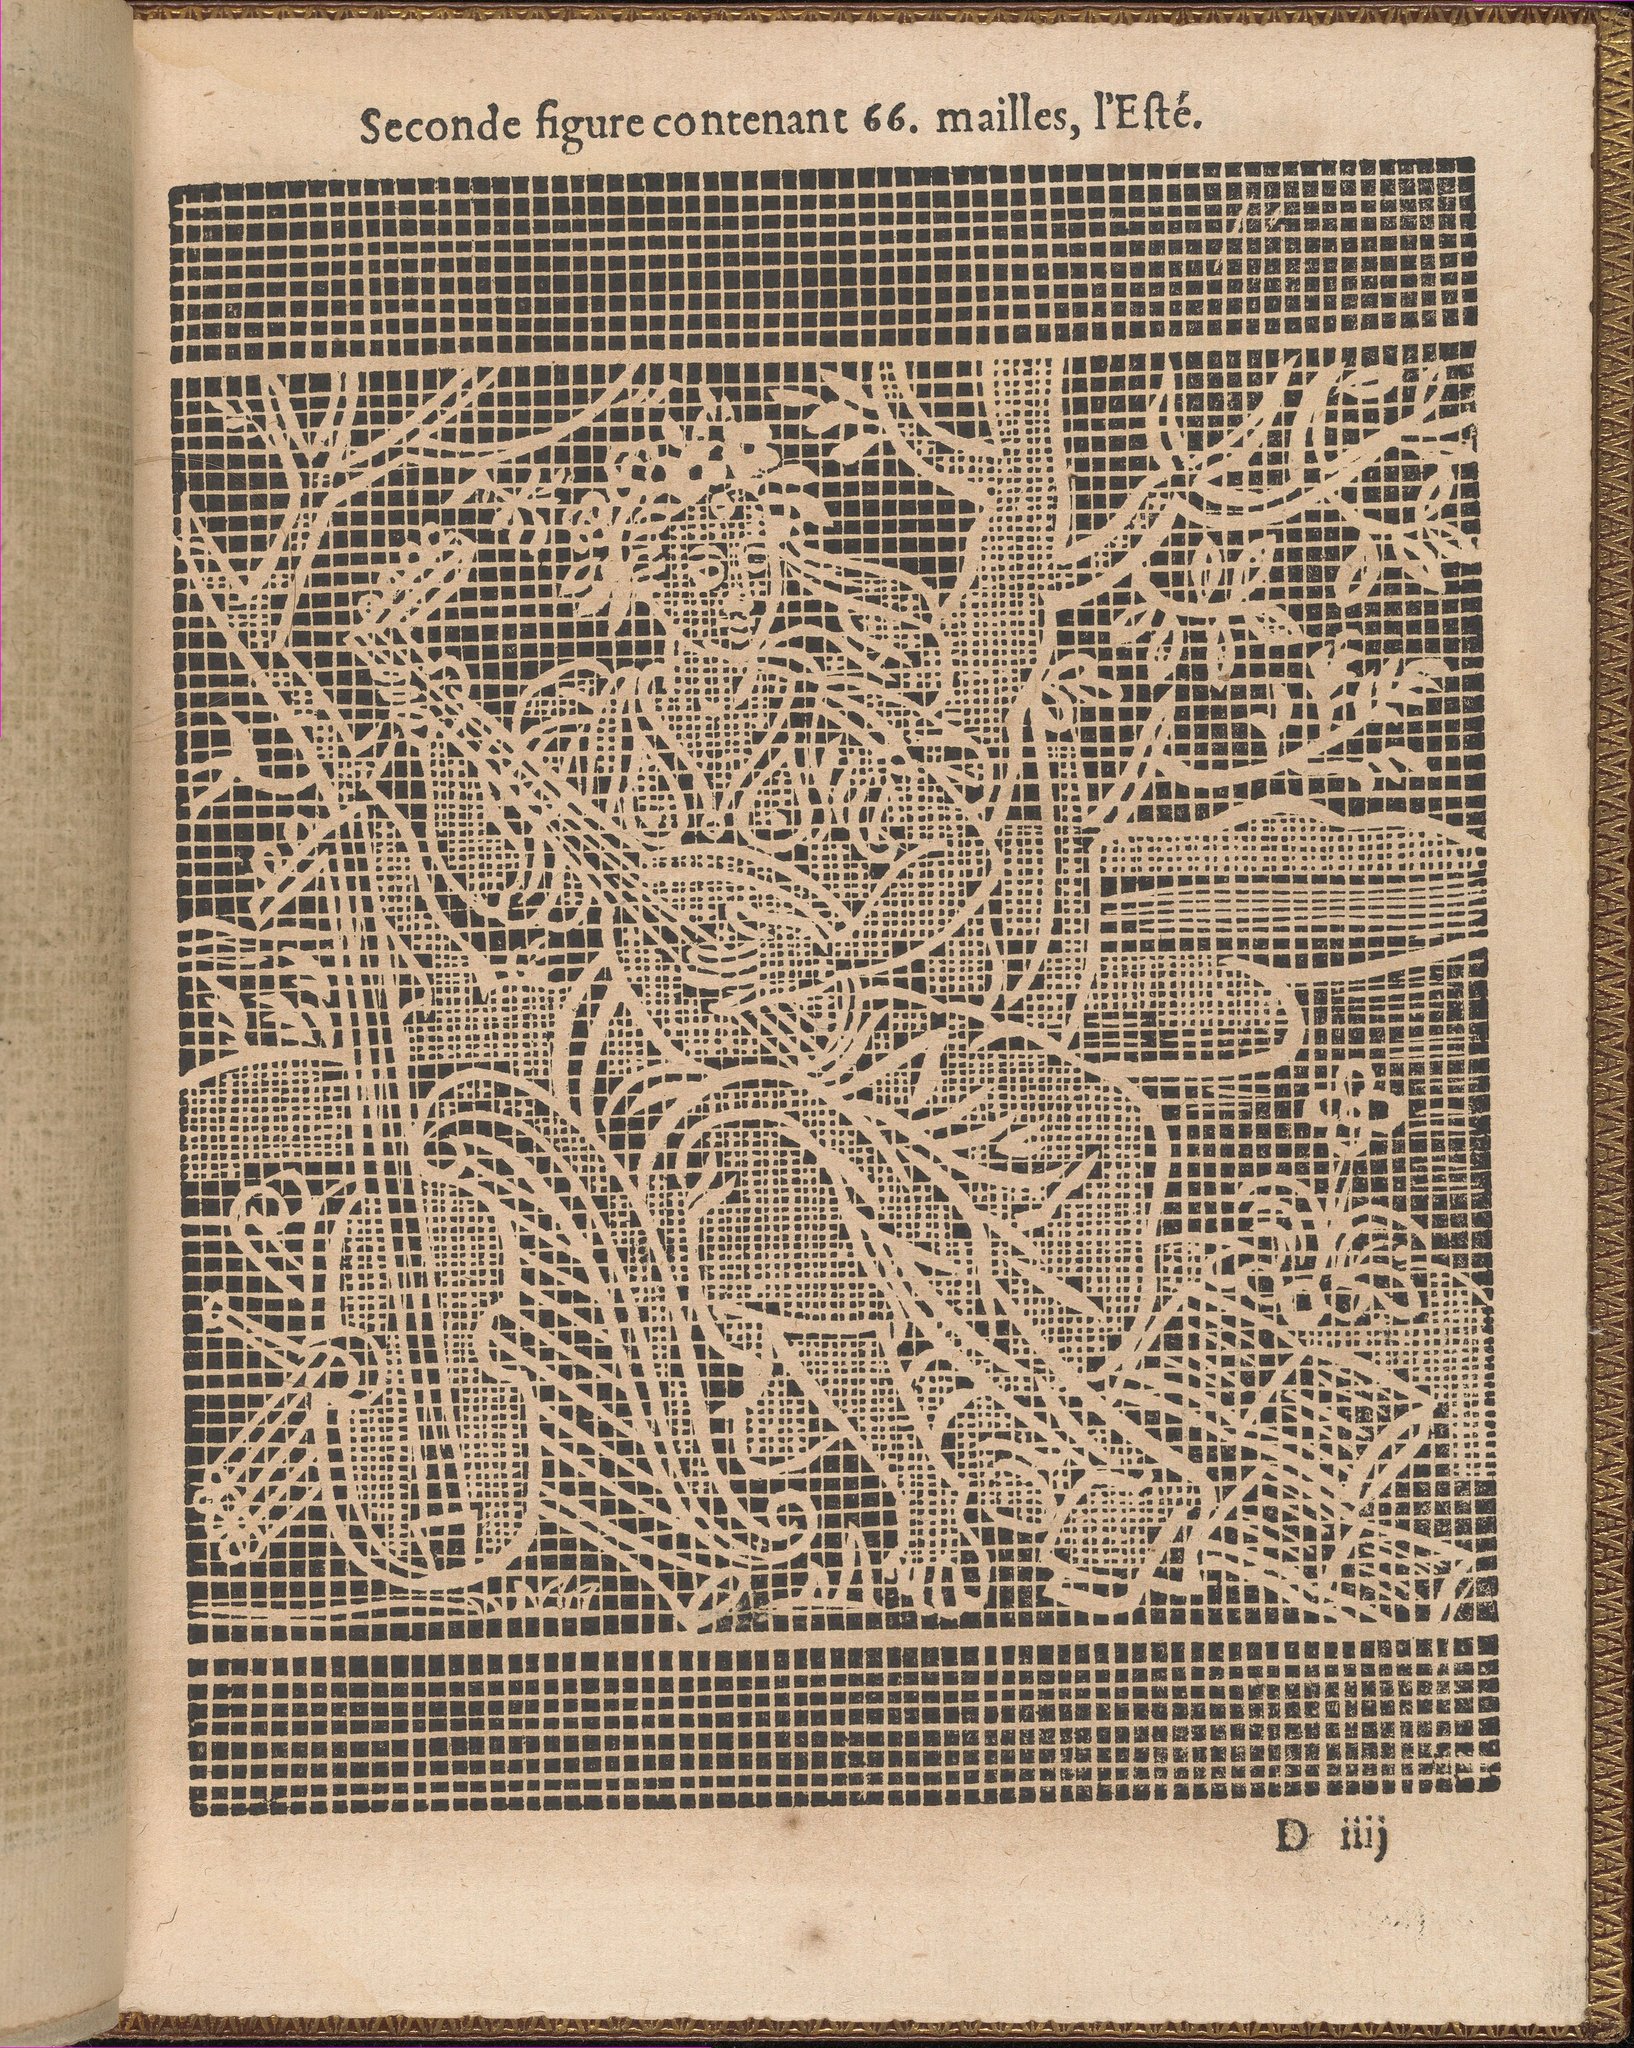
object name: book print ornament architecture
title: La Pratique de l'Aiguille, page 15 (recto)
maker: matthias mignerak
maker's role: author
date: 1605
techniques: woodcut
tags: musical instruments,girls